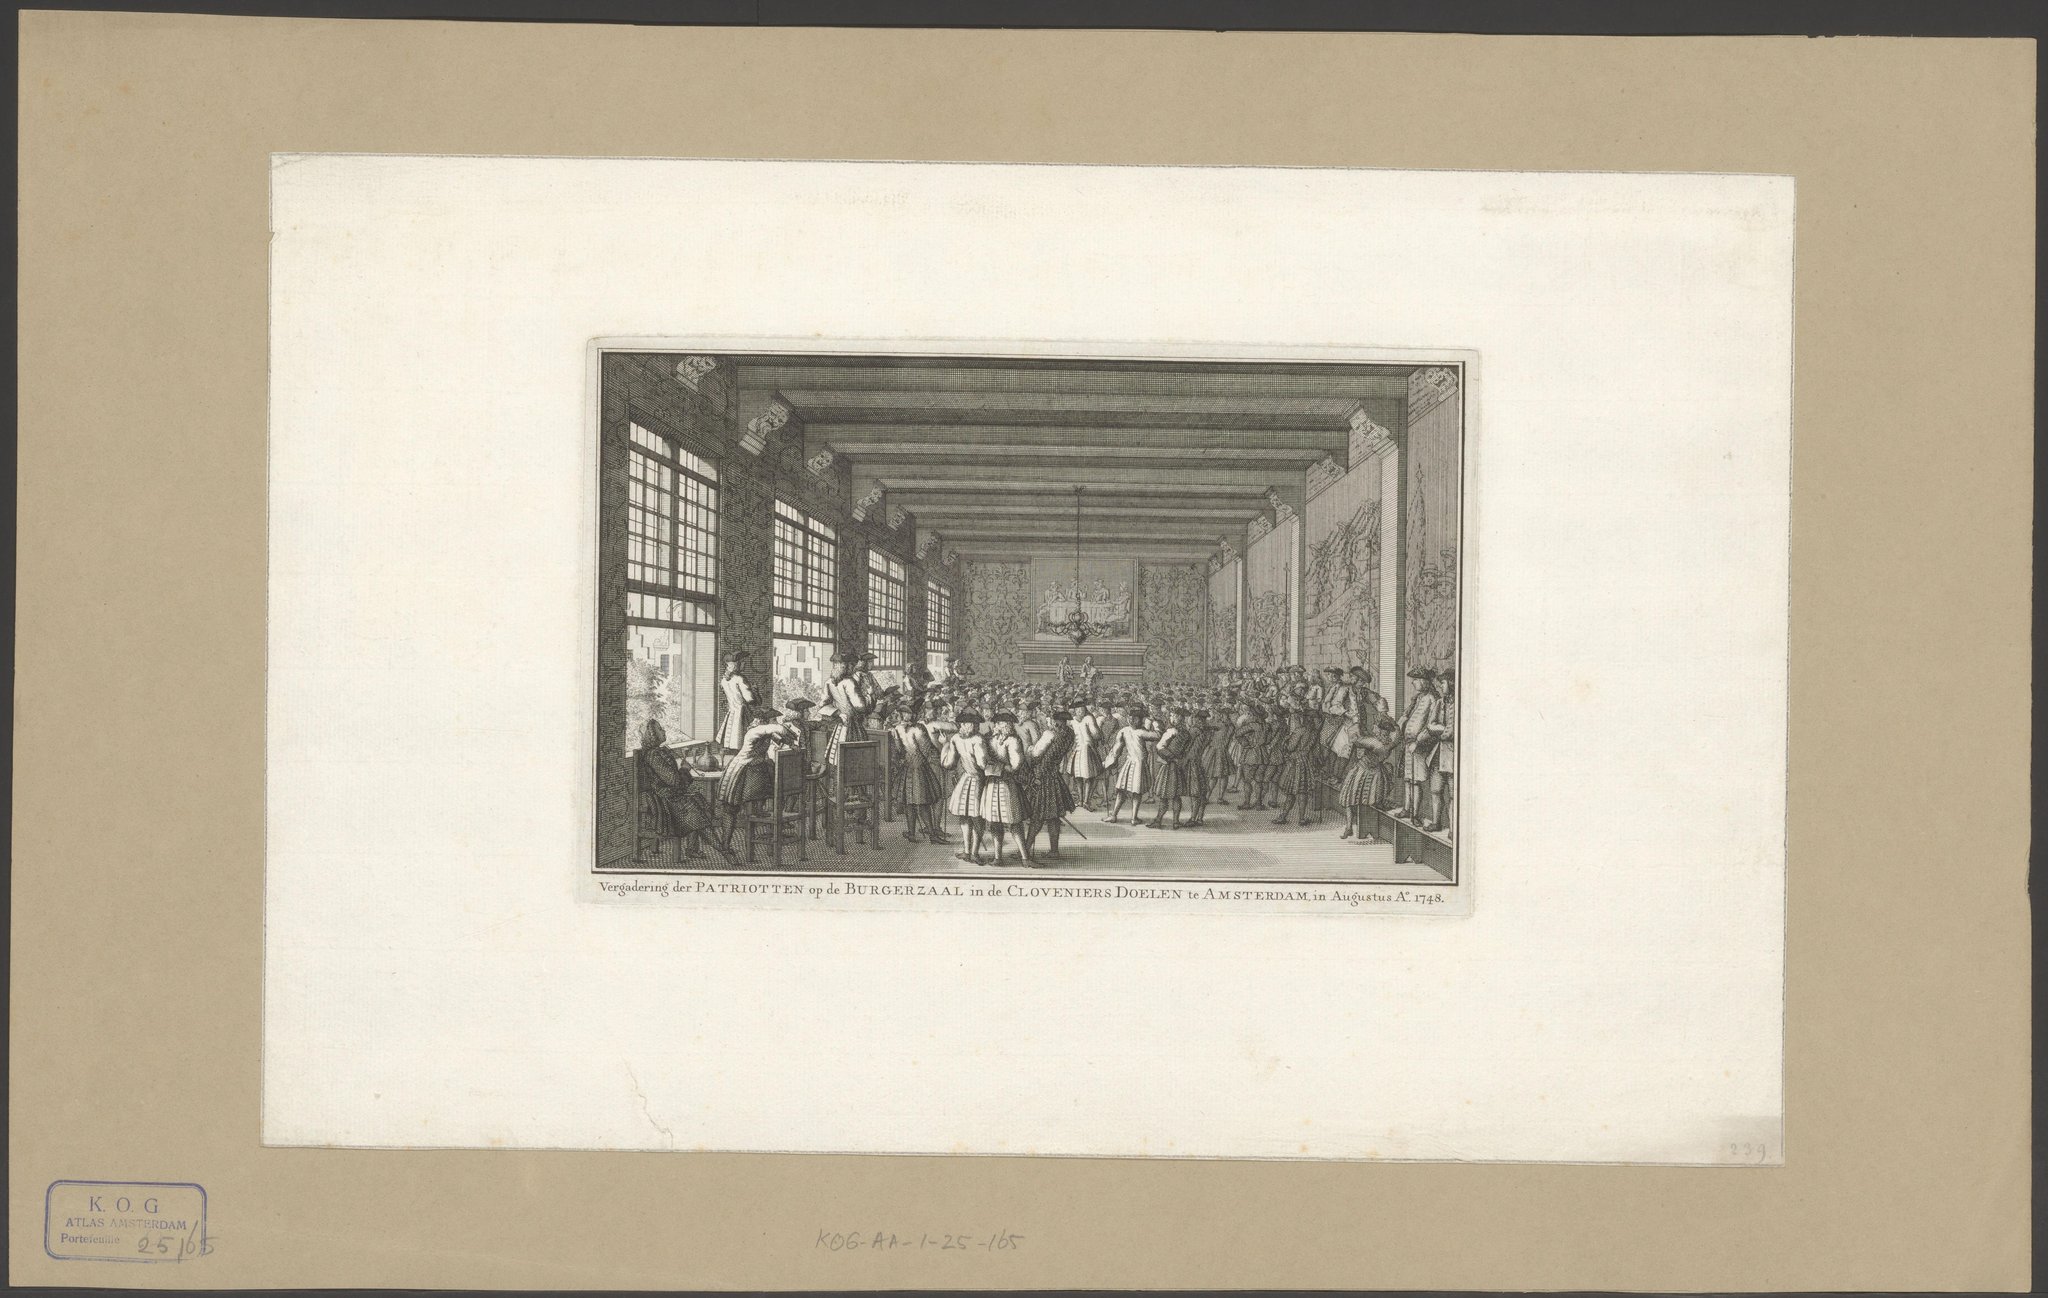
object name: print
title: Vergadering der Patriotten op de Burgerzaal in de Cloveniers Doelen te Amsterdam, in augustus Ao. 1748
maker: Anonymous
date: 1748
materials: paper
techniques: engraving, etching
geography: northern netherlands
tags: meeting, assembly, political meeting, propaganda meeting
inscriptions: collector's mark: ‘25.165’ Lugt 1641b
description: Onderwerpsrubriek binnen de Atlas Amsterdam: Krijgswezen I: De Admiraliteit van Amsterdam, E. Doelen en Wachthuizen.